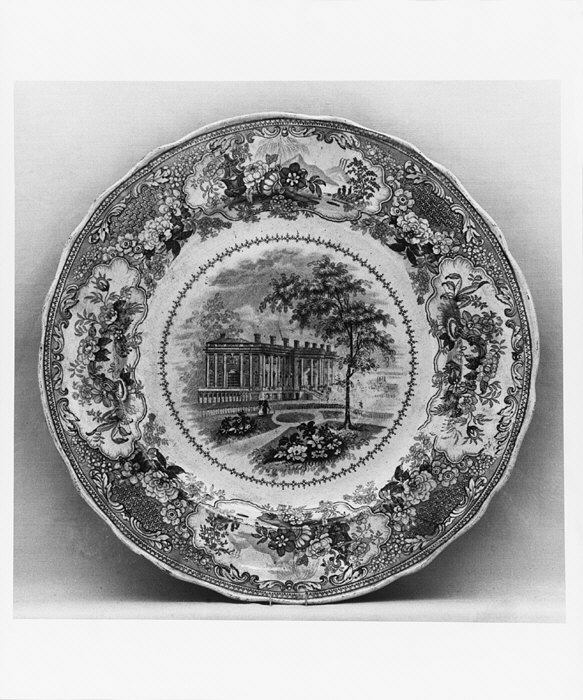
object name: plate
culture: british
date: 1830-1840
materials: earthenware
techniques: transfer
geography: england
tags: buildings,flowers,trees